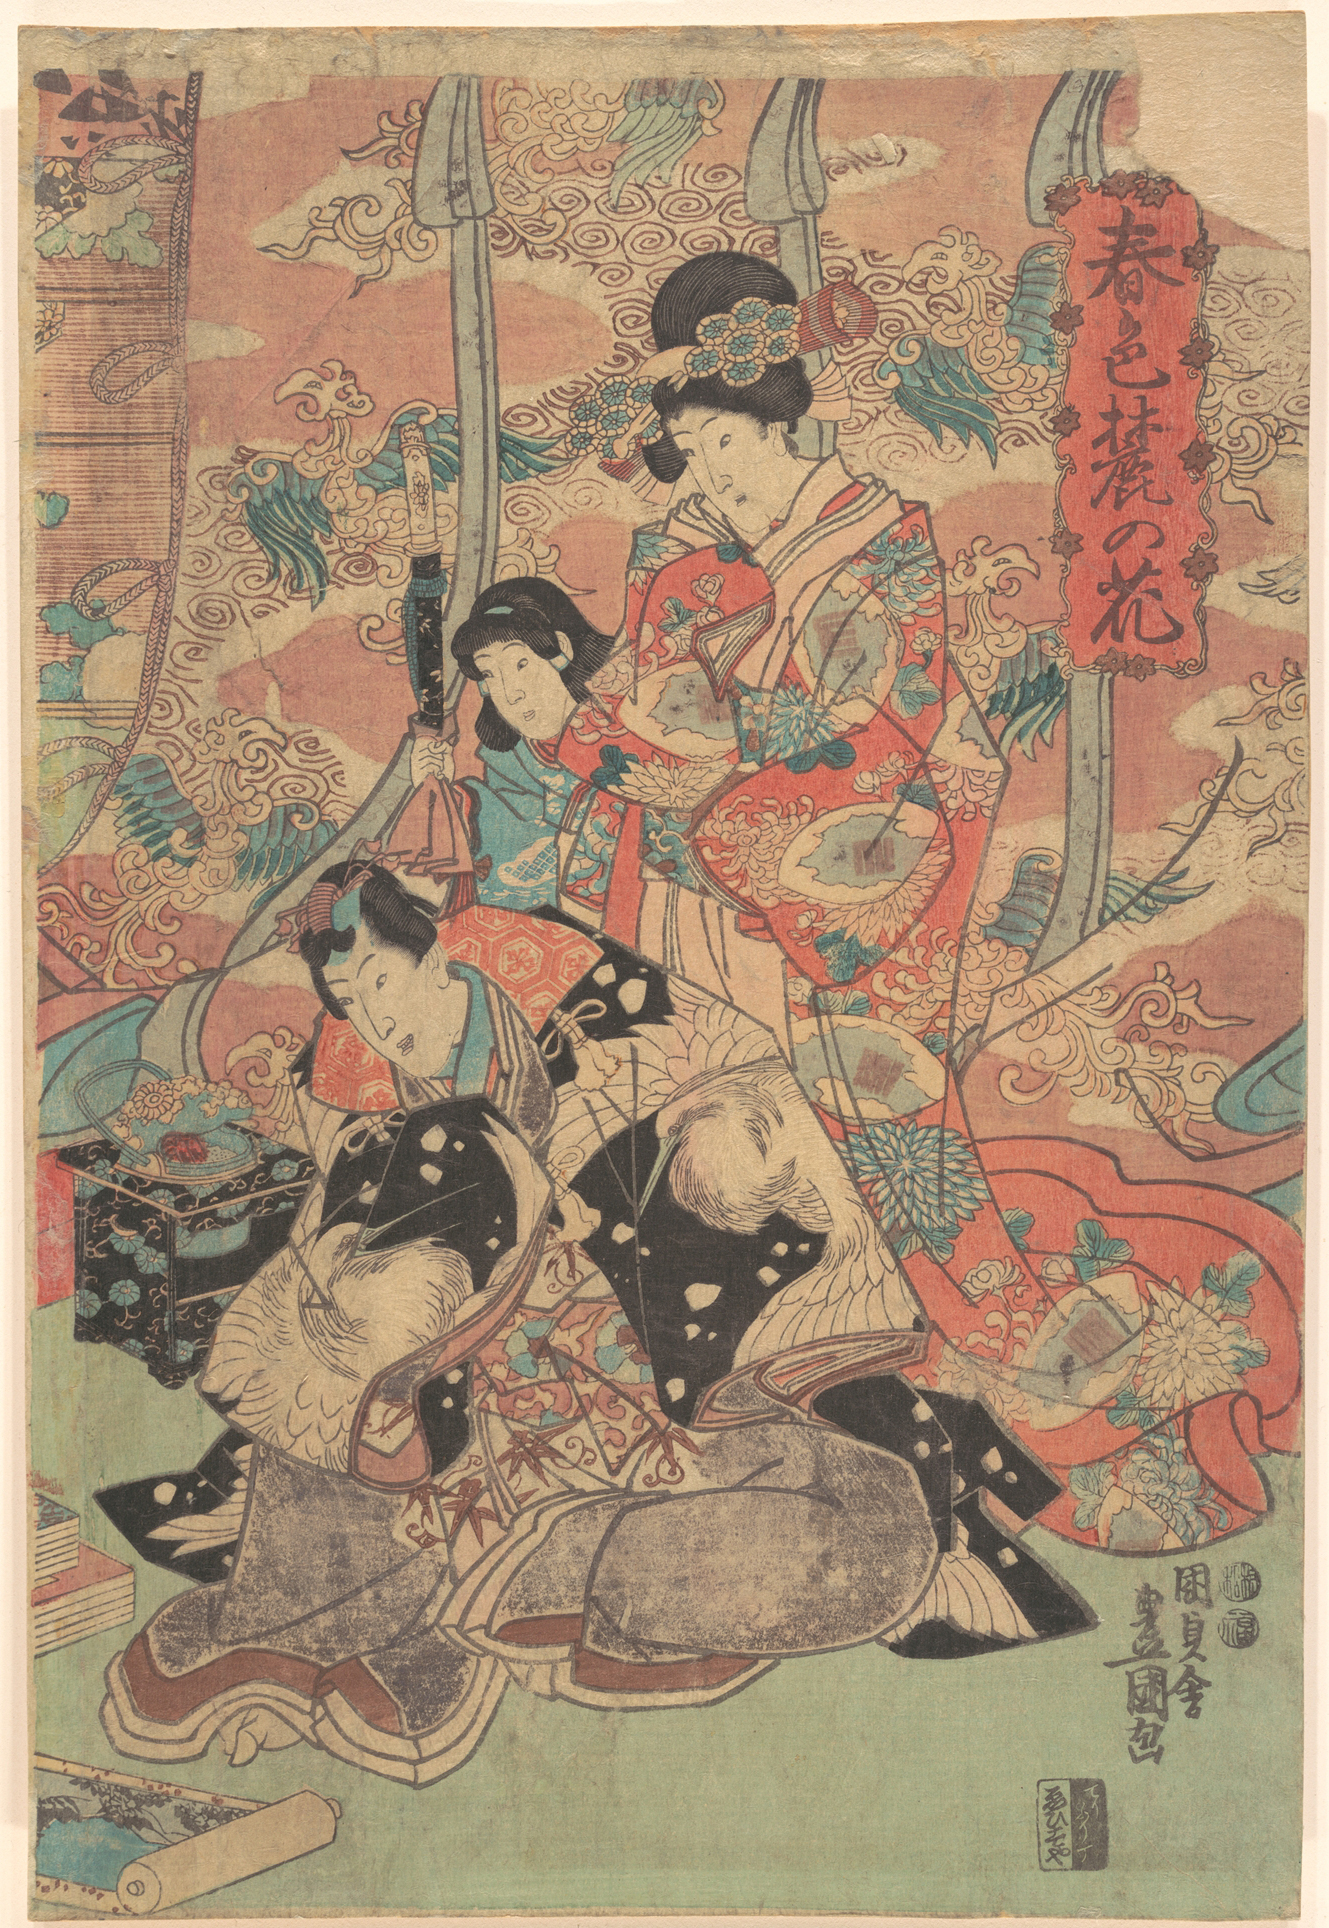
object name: print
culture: japanese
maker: utagawa kunisada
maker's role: artist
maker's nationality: japanese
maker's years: 1786-1864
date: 1786-1854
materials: ink, paper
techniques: woodblock print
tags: men,women